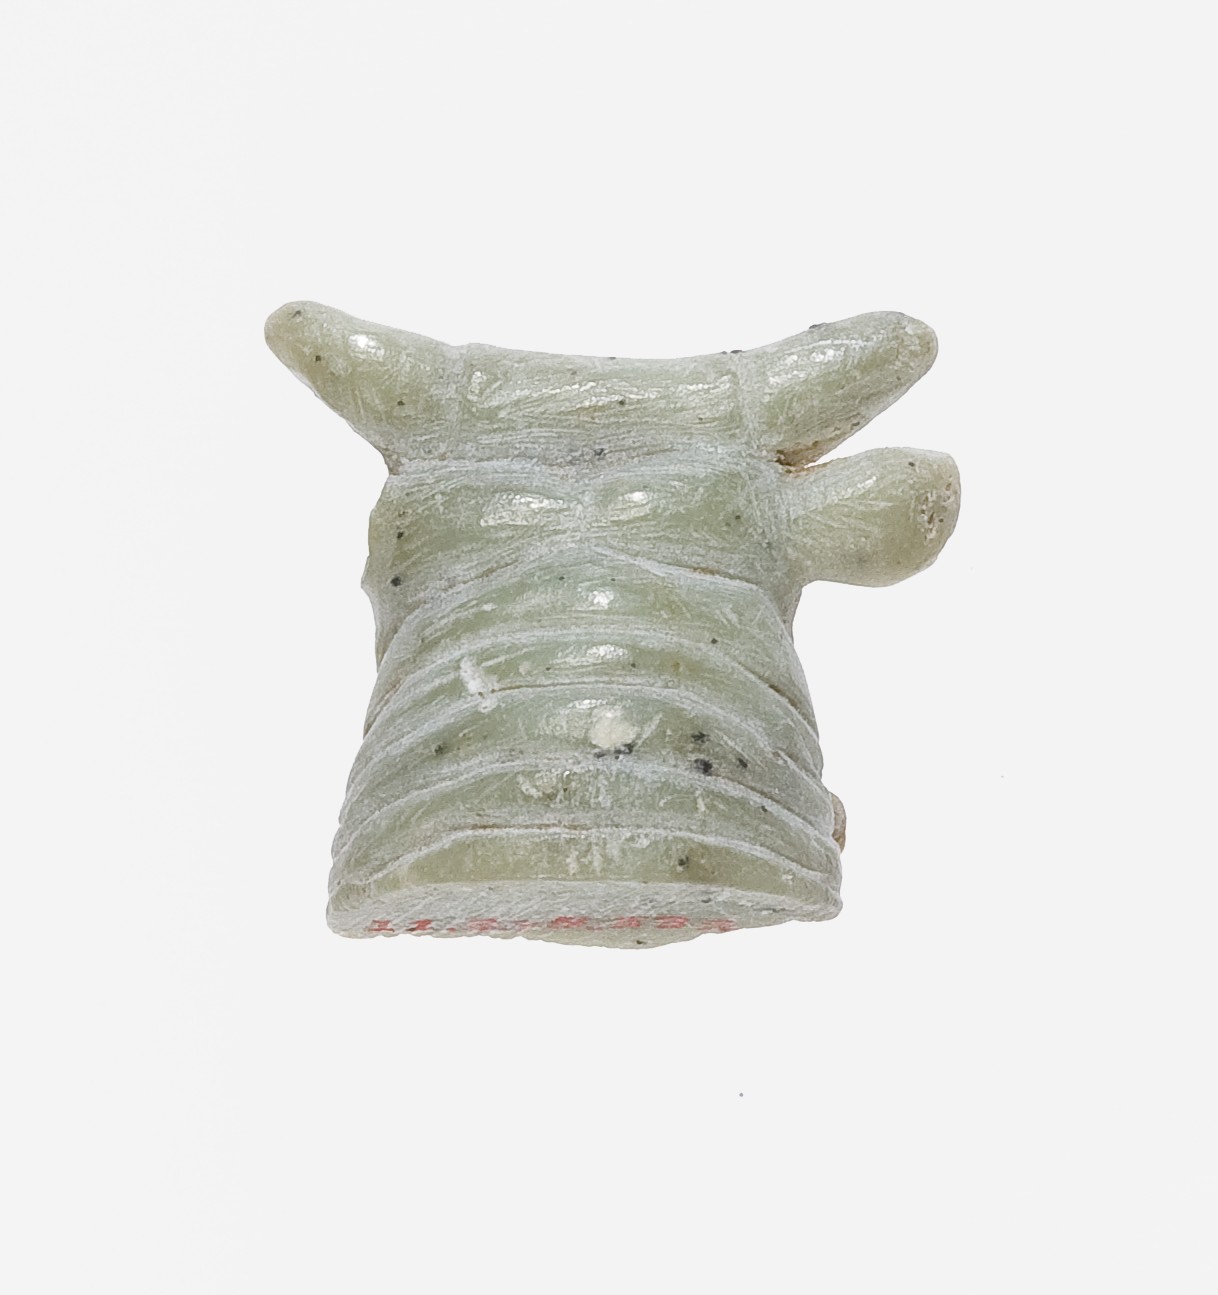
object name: game piece, bull head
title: Gamepiece: Bull's Head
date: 1390-1352 BCE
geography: egypt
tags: bulls